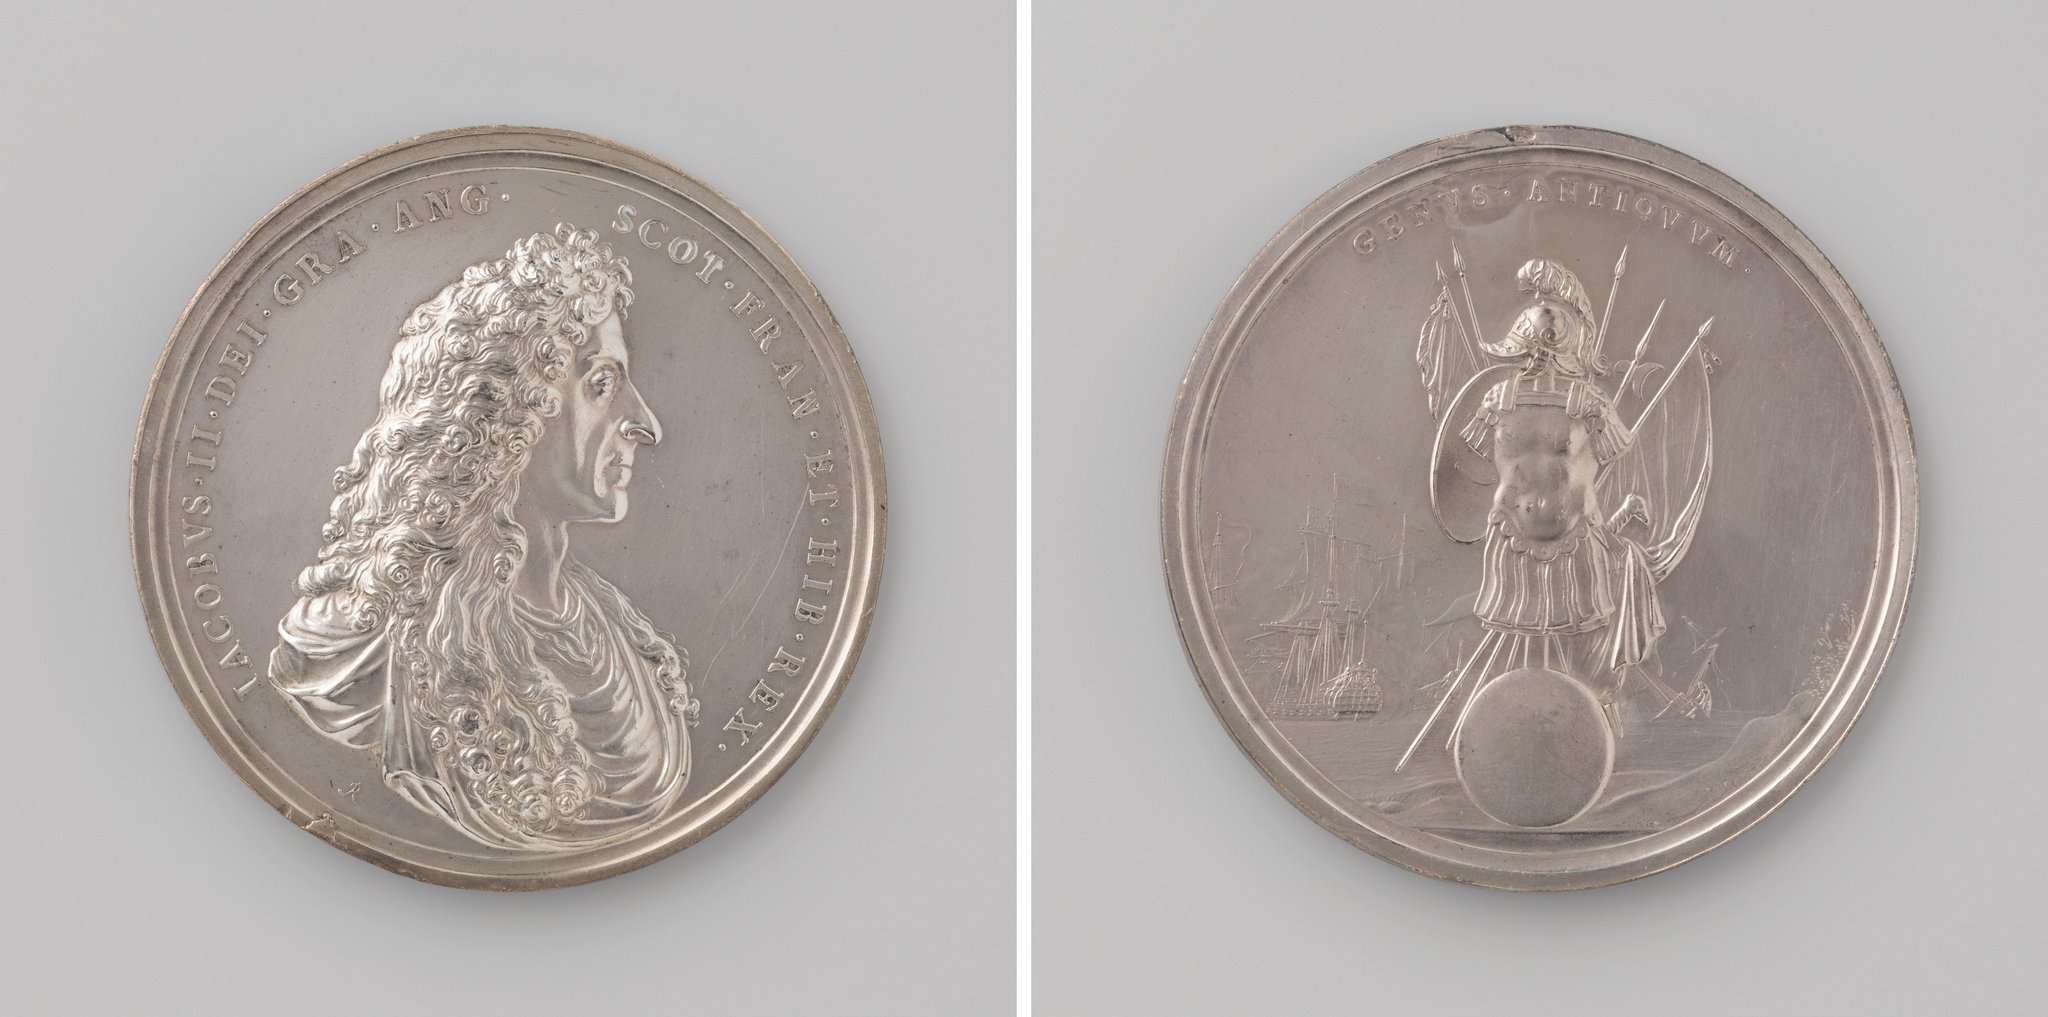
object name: history medal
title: Jacobus II, koning van Engeland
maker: jean roëttiers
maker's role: medailleur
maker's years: 1631-1703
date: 1665-1685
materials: silver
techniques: striking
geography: london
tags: jacobus ii (koning van engeland en schotland)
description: Zilveren penning. Voorzijde: borststuk man binnen omschrift. Keerzijde: zegeteken op strand met op achtergrond zeeslag binnen omschrift.